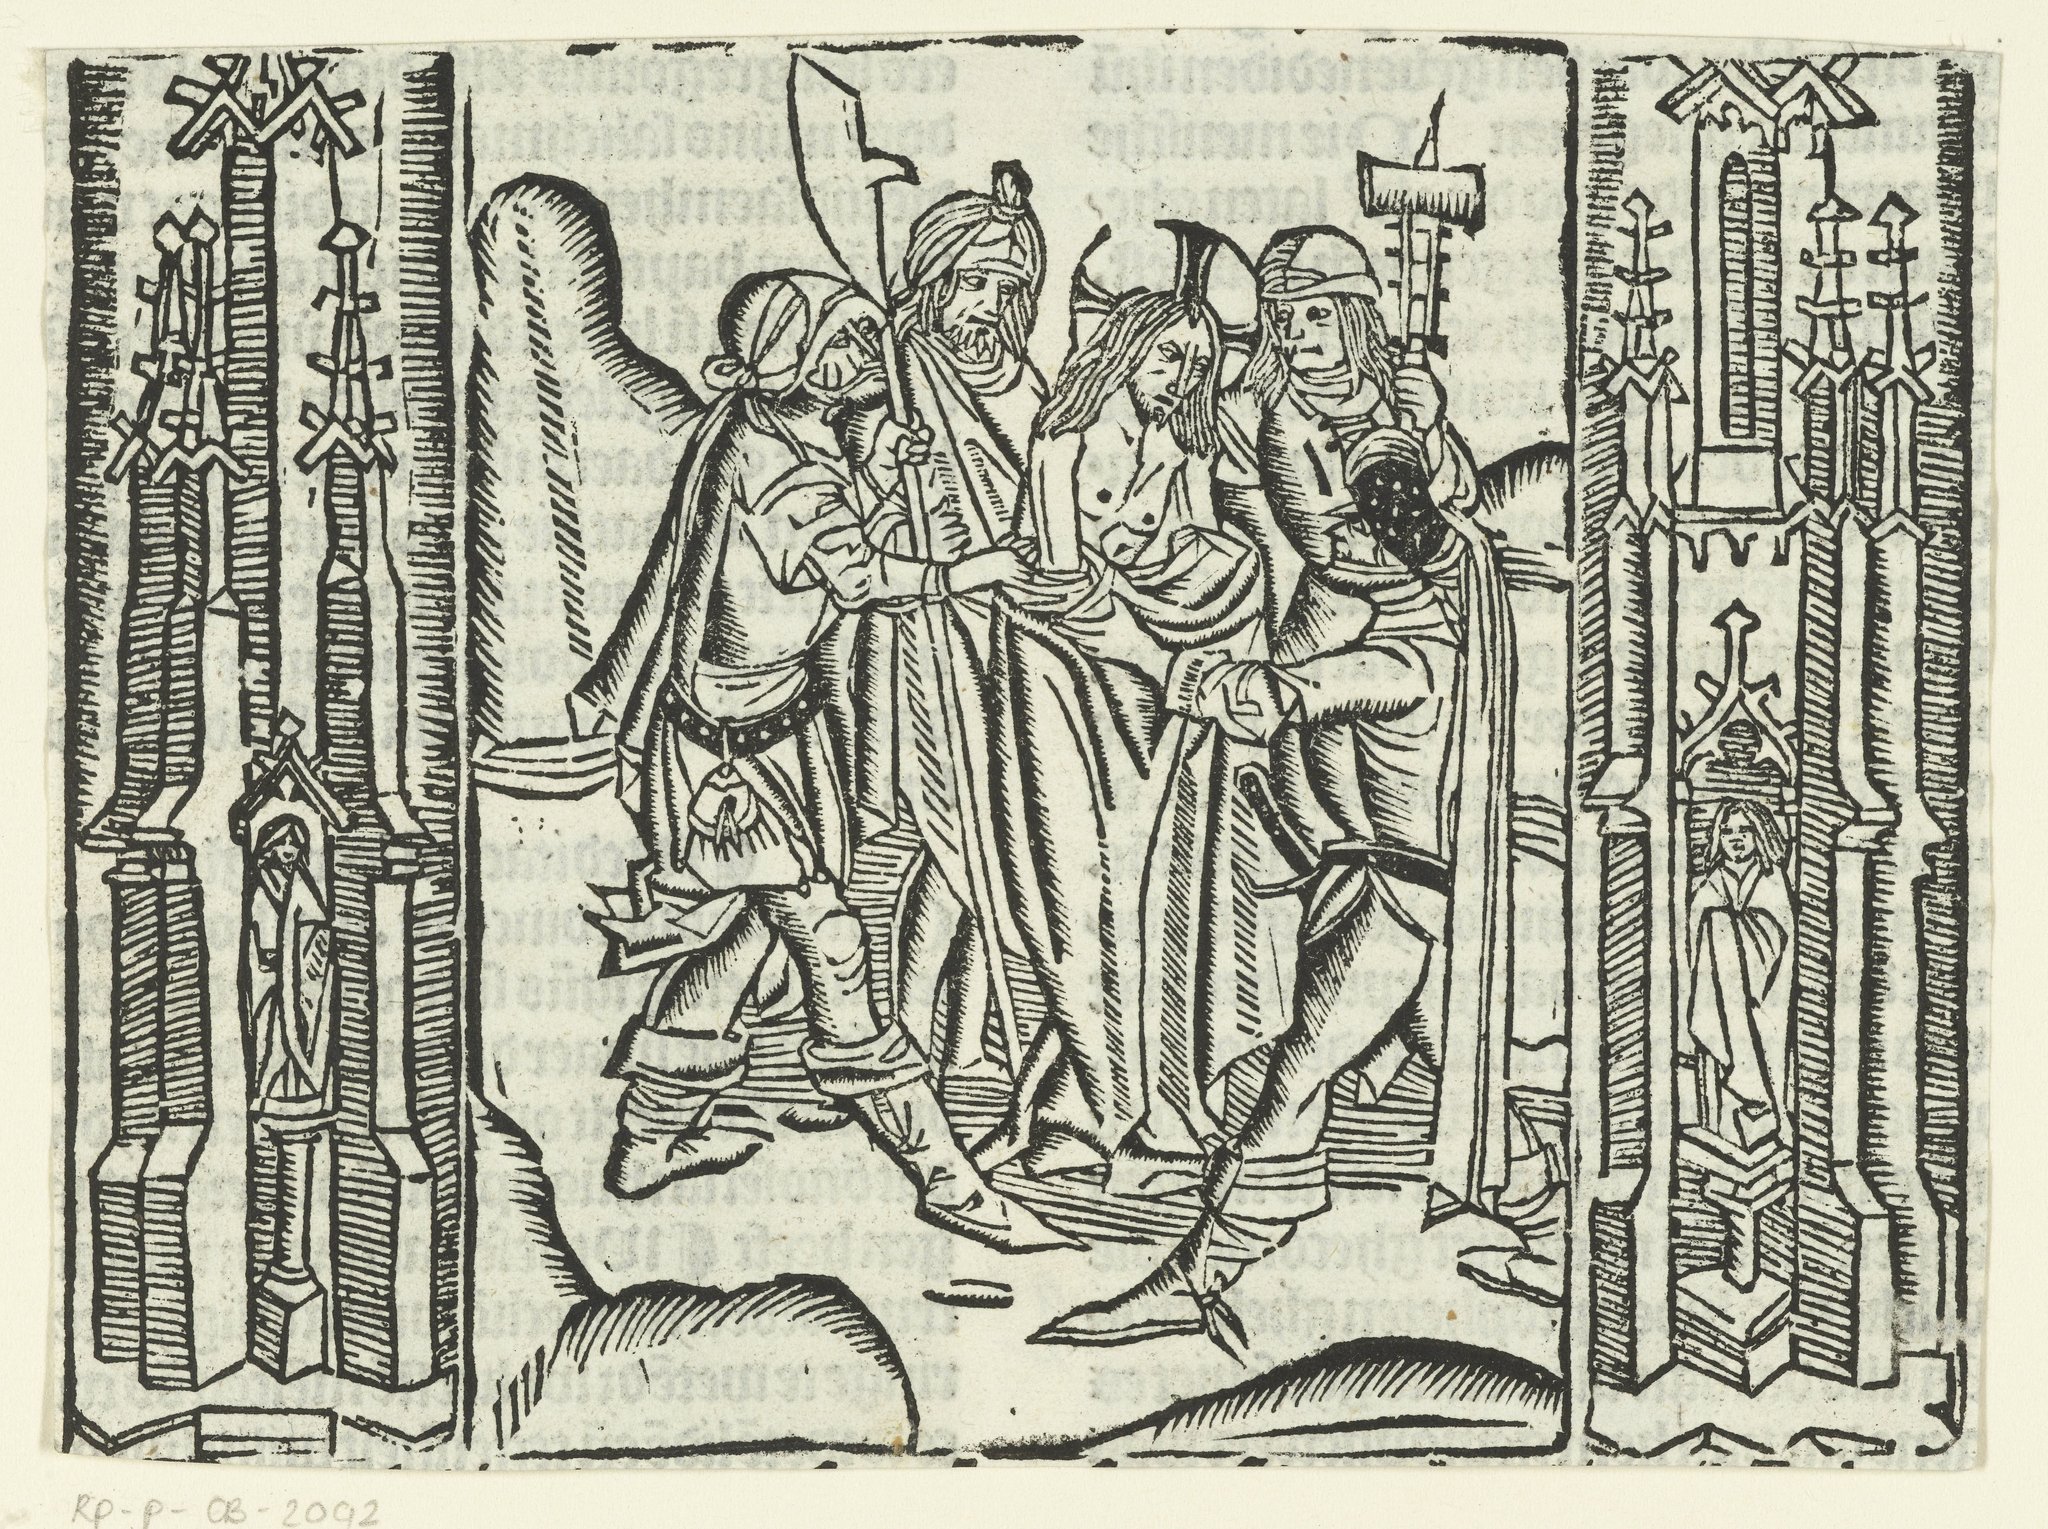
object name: book illustration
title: Christus wordt ontkleed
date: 1480-1500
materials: paper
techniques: woodcut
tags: christ disrobed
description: Eén blad van 113 uit Ludolphus de Saxonia, "Dit es dleué ons liefs heeren ihesu christi". Anonieme Nederlandse vertaling. Uitgegeven door Henrick Eckert van Homberch te Antwerpen in 1503. Botke, K. Deze 113 houtsneden, die meestal reeds in vroege Nederlandse boeken gebruikt zijn, worden toegeschreven aan de tweede Meester van Delft, de Meester van de Delbecq-Schreiber-passie en de Meester van de Virgo inter Virgines. In Conway (1884) en in "De gulden passer"(1951) zijn ook eerdere versies opgenomen. Botke, K.